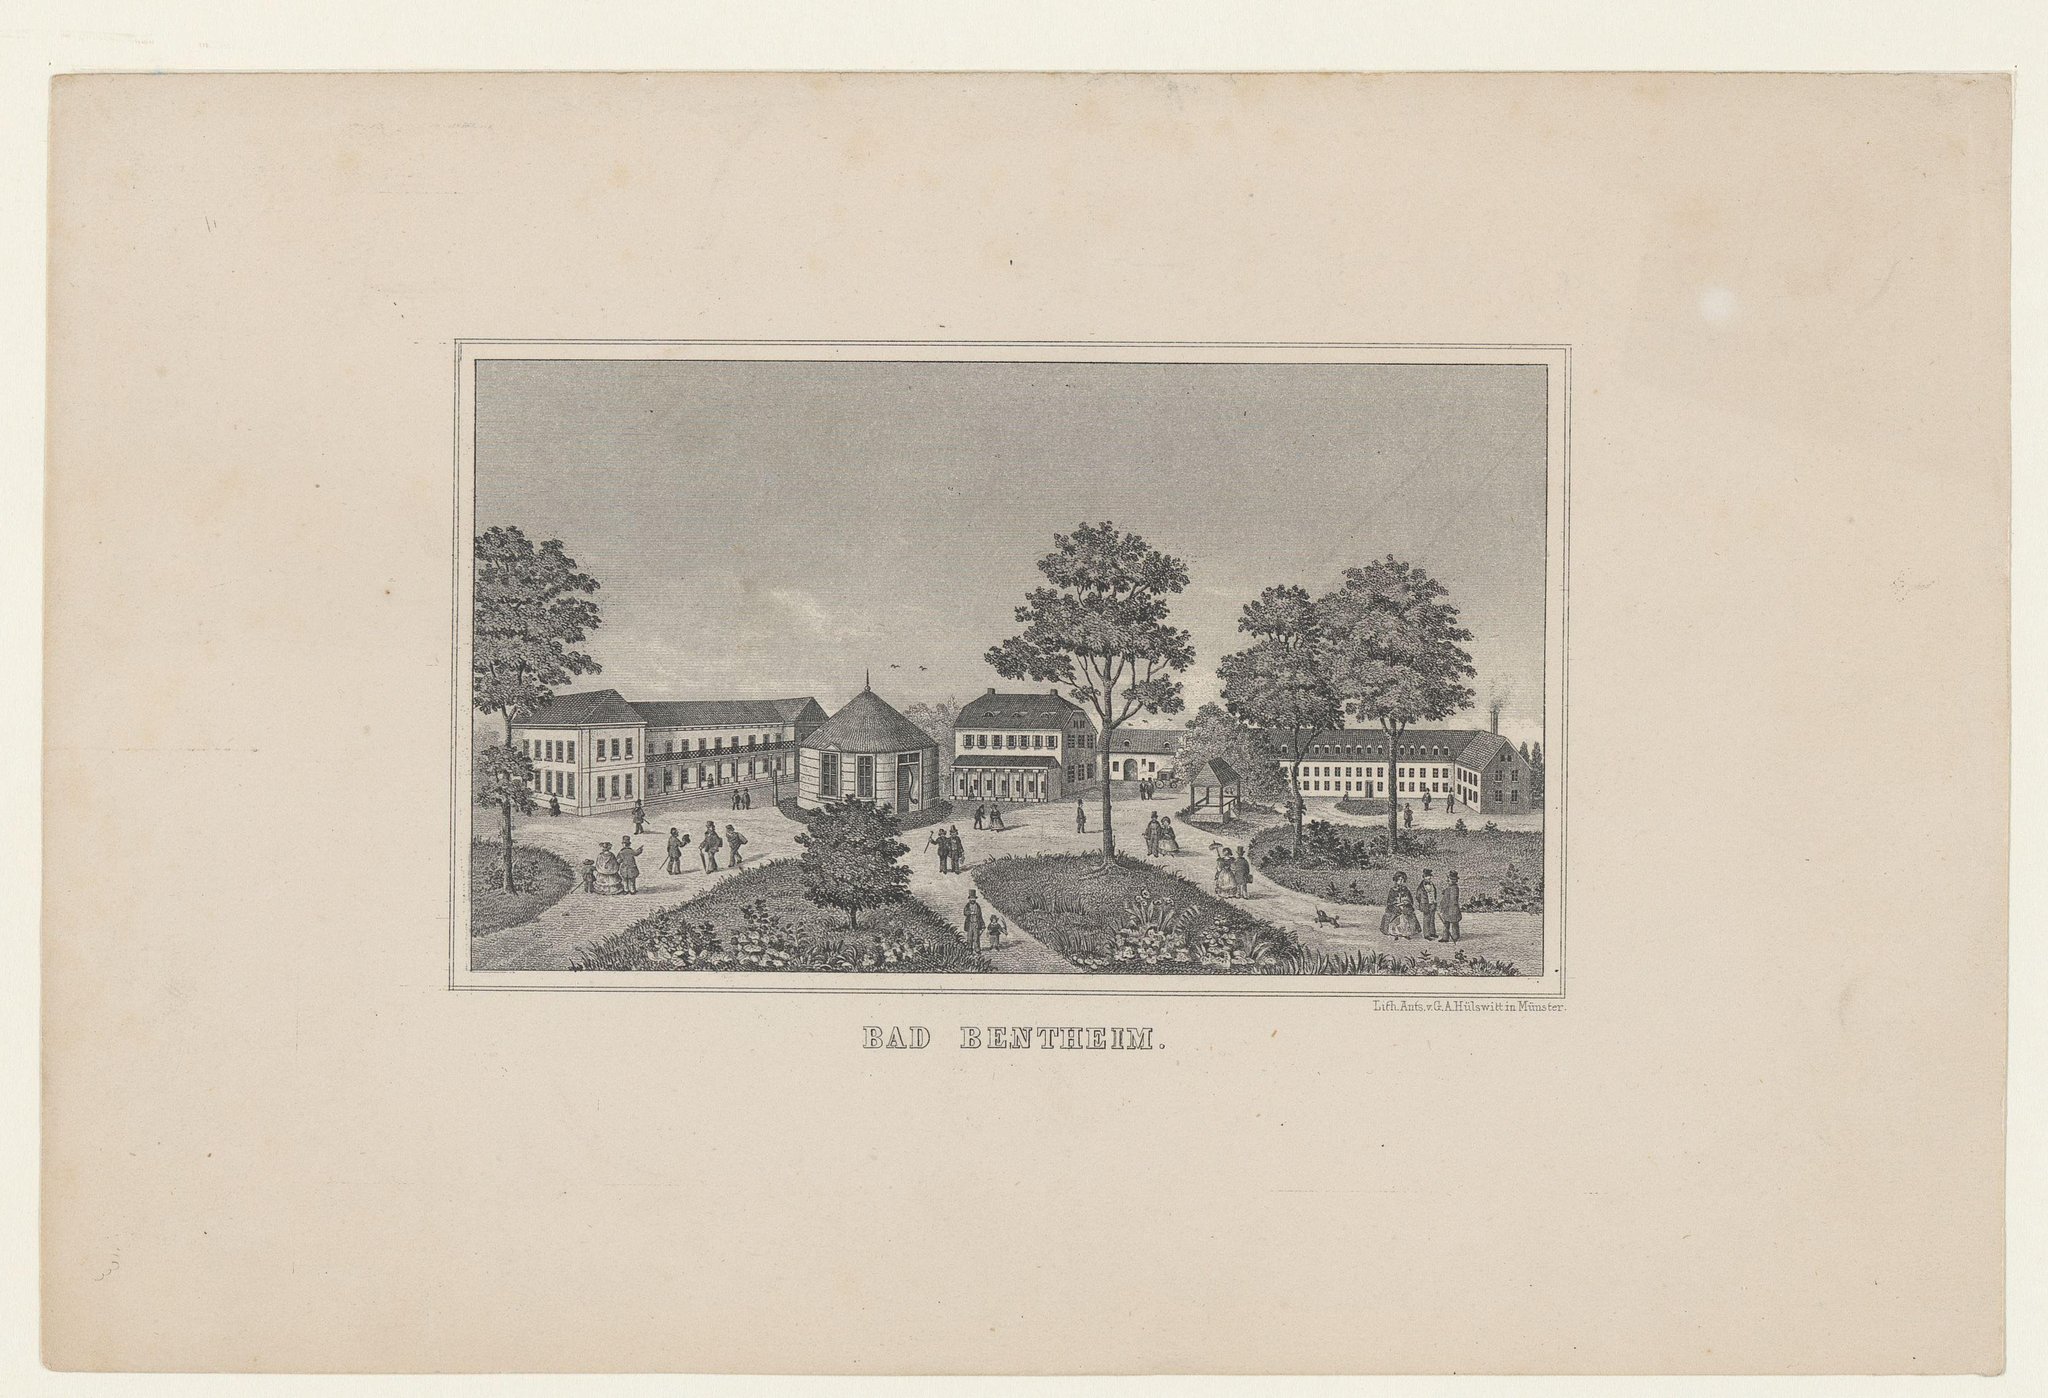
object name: print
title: Bad Bentheim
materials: paper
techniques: engraving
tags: prospect of village, silhouette of village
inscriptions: collector's mark: Lugt 2228